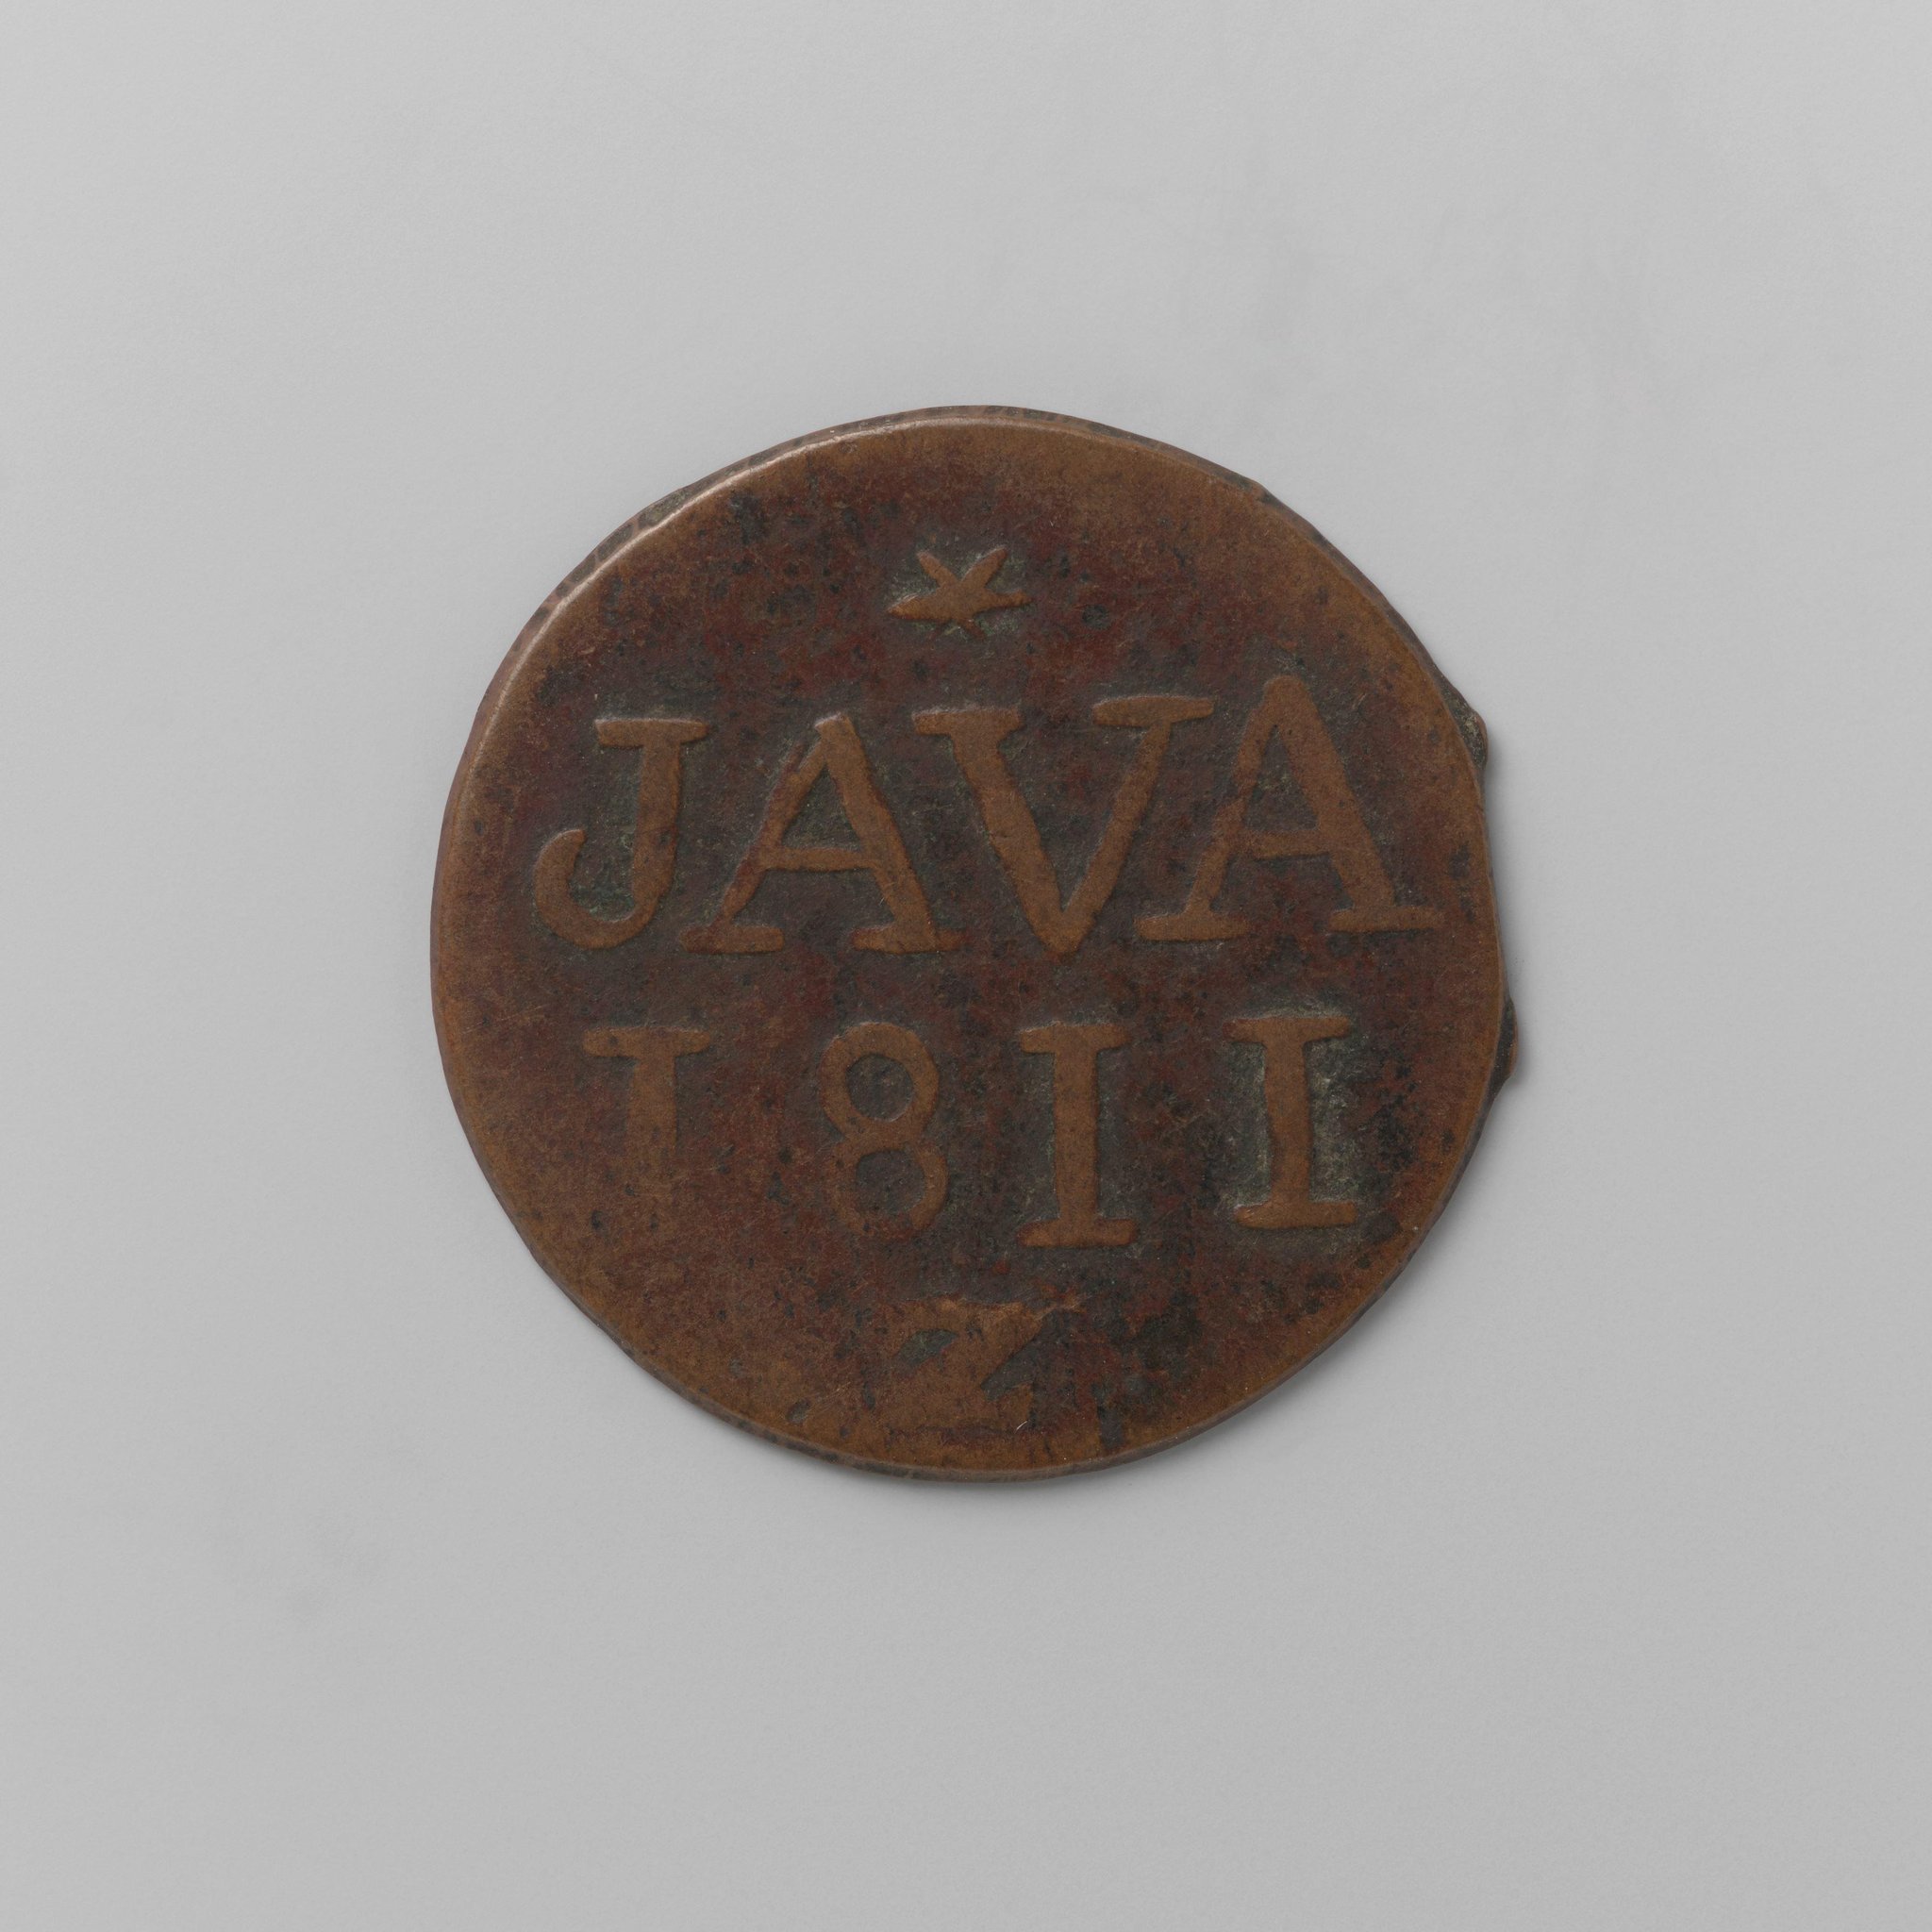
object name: coin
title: Nederlands Indië tijdens Brits bestuur, duit Java,1811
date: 1811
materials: copper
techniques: striking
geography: surabaya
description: Koperen munt. Voorzijde: monogram van de Engelse Oostindische Compagnie. Daarboven letter B [=British]. Keerzijde: eenregelig opschrift, waaronder jaartal. Boven opschrift muntteken en onder jaartal muntmeesterteken Z [=muntmeester Zwekkert].